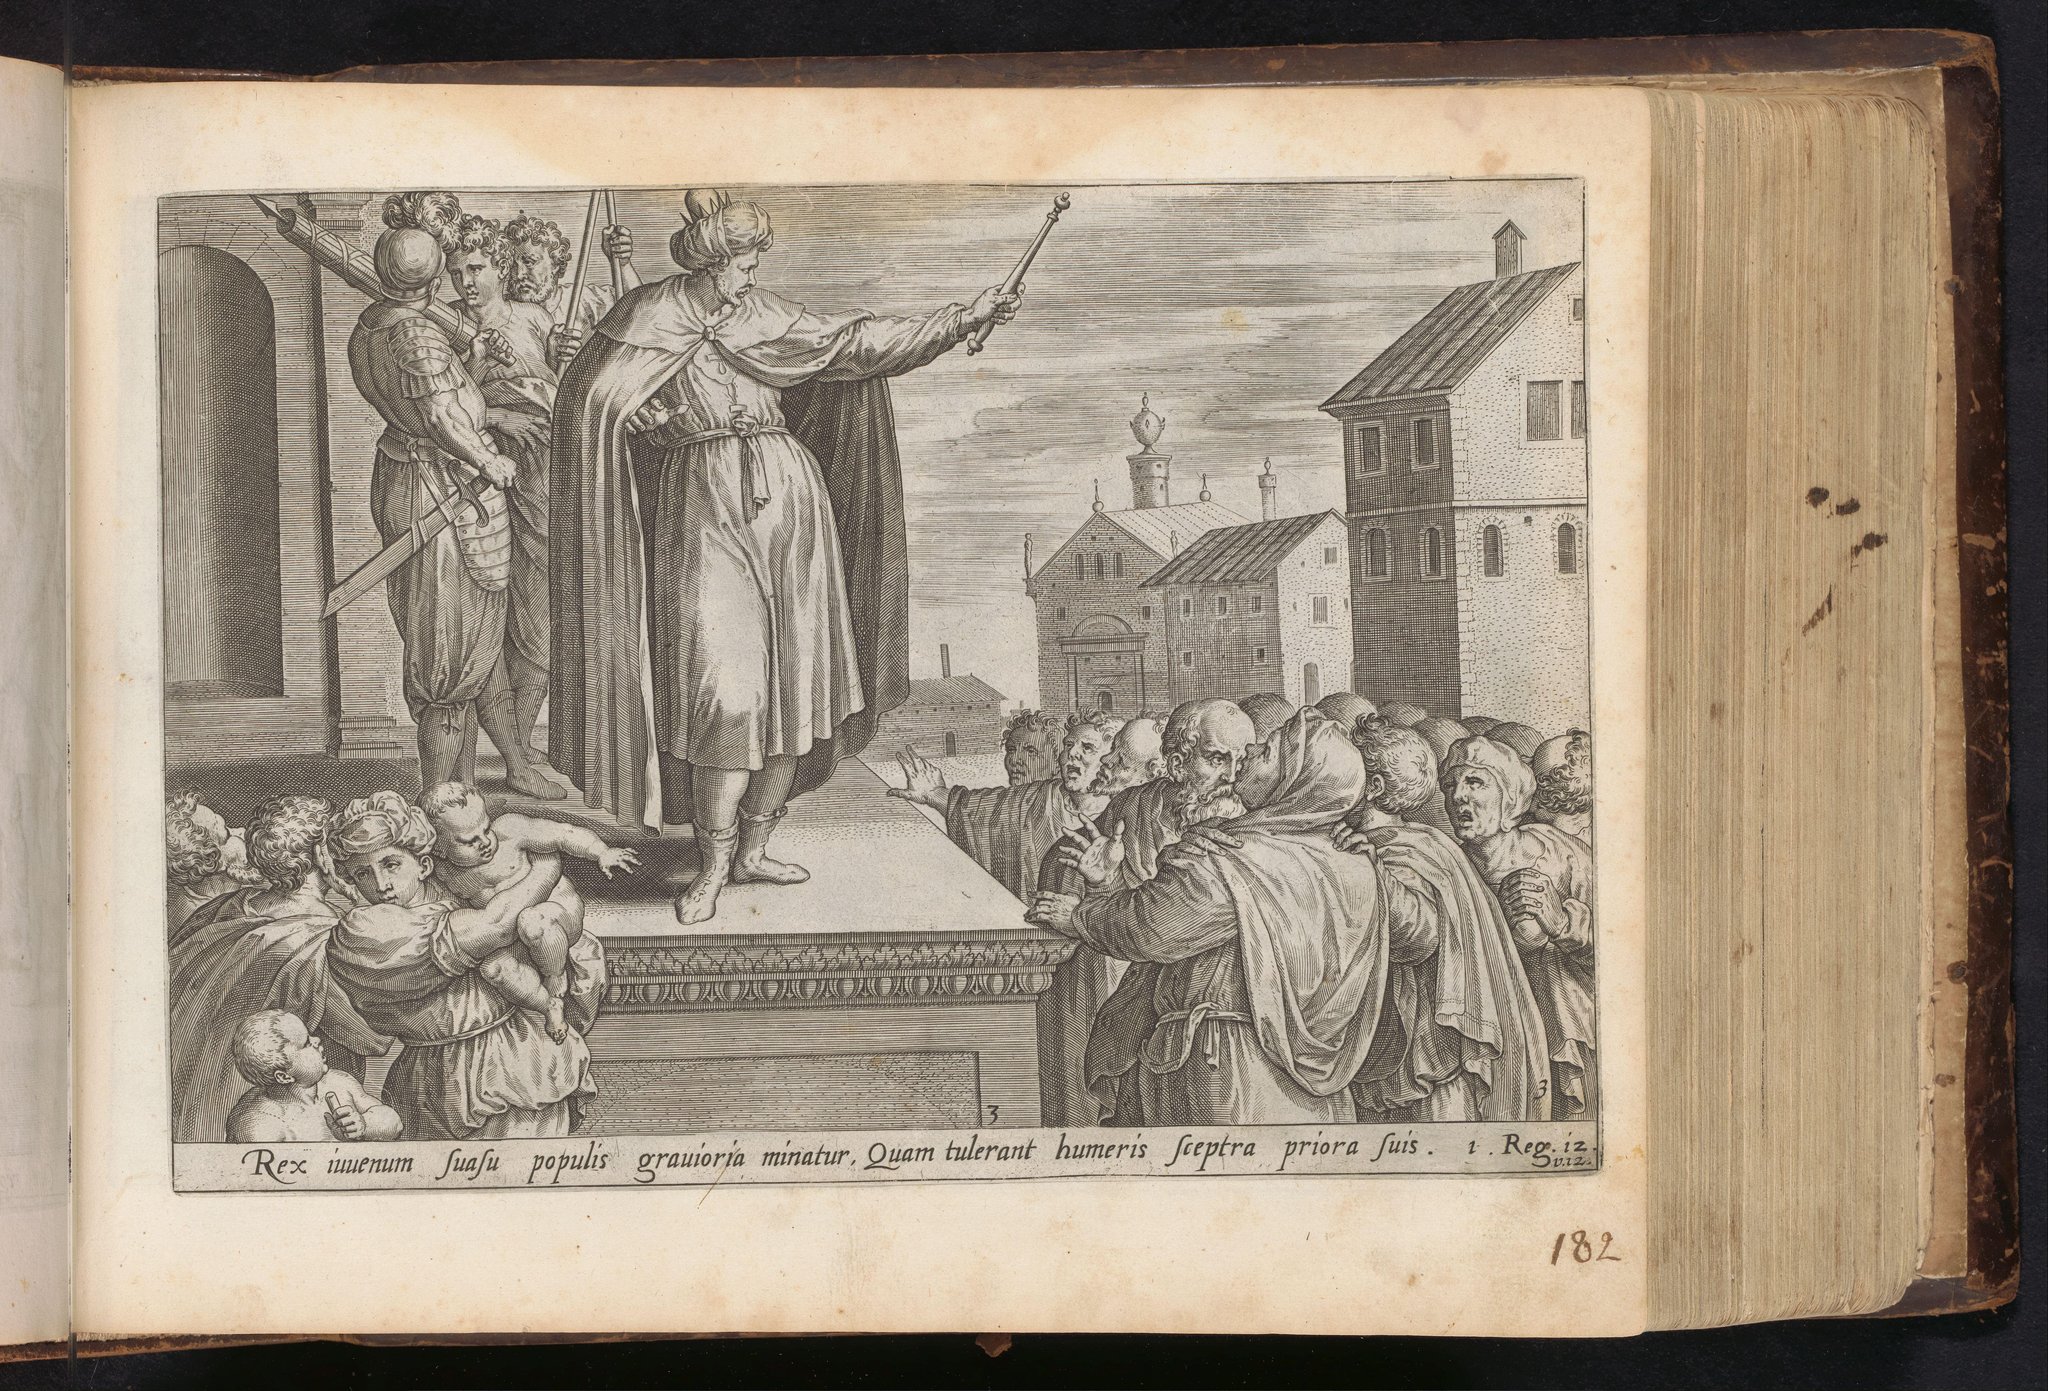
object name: print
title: Den Grooten Figuer-Bibel (...)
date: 1579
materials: paper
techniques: engraving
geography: alkmaar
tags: rehoboam's insulting reply: forsaking the warning of the wise old counsel- lors but following the young advisers' opinion, rehoboam not only refuses to lessen the taxes, but increases them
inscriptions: number: ‘182’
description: Koning Rechabeam geeft het volk Israël antwoord op hun verzoek tot verlichting van hun juk. Hij staat op een podium en deelt de mensen mee dat hij hun juk nog zal verzwaren. De mensen reageren verschrikt. De Israëlieten breken met Rechabeam, die alleen koning blijft over de steden van Juda. Onder de voorstelling een verwijzing in het Latijn naar de Bijbeltekst in 1 Kon. 12:12. Deze prent maakt deel uit van een album.